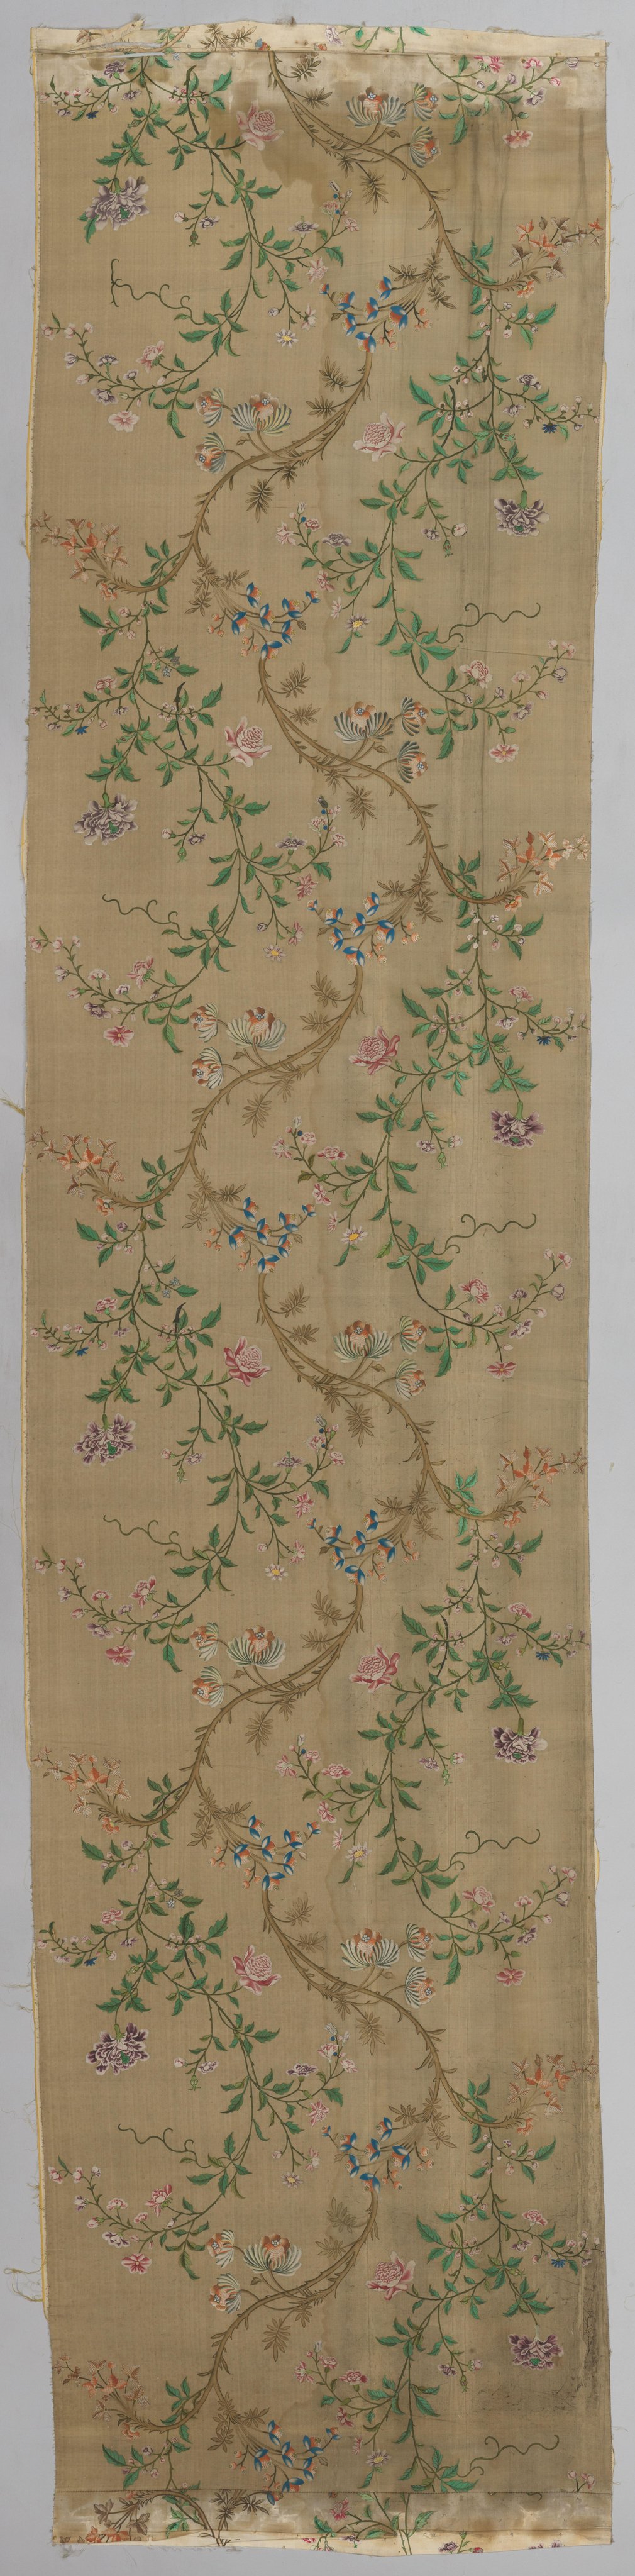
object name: upholstery fabric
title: Bespanningsstof met decor van takken, bladeren, bloemen en vruchten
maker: Anonymous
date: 1750-1790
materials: paint, silk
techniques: printing, weave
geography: china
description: Een baan veelkleurig beschilderde creme bespanningsstof van zijde. Beschrijving zie A.